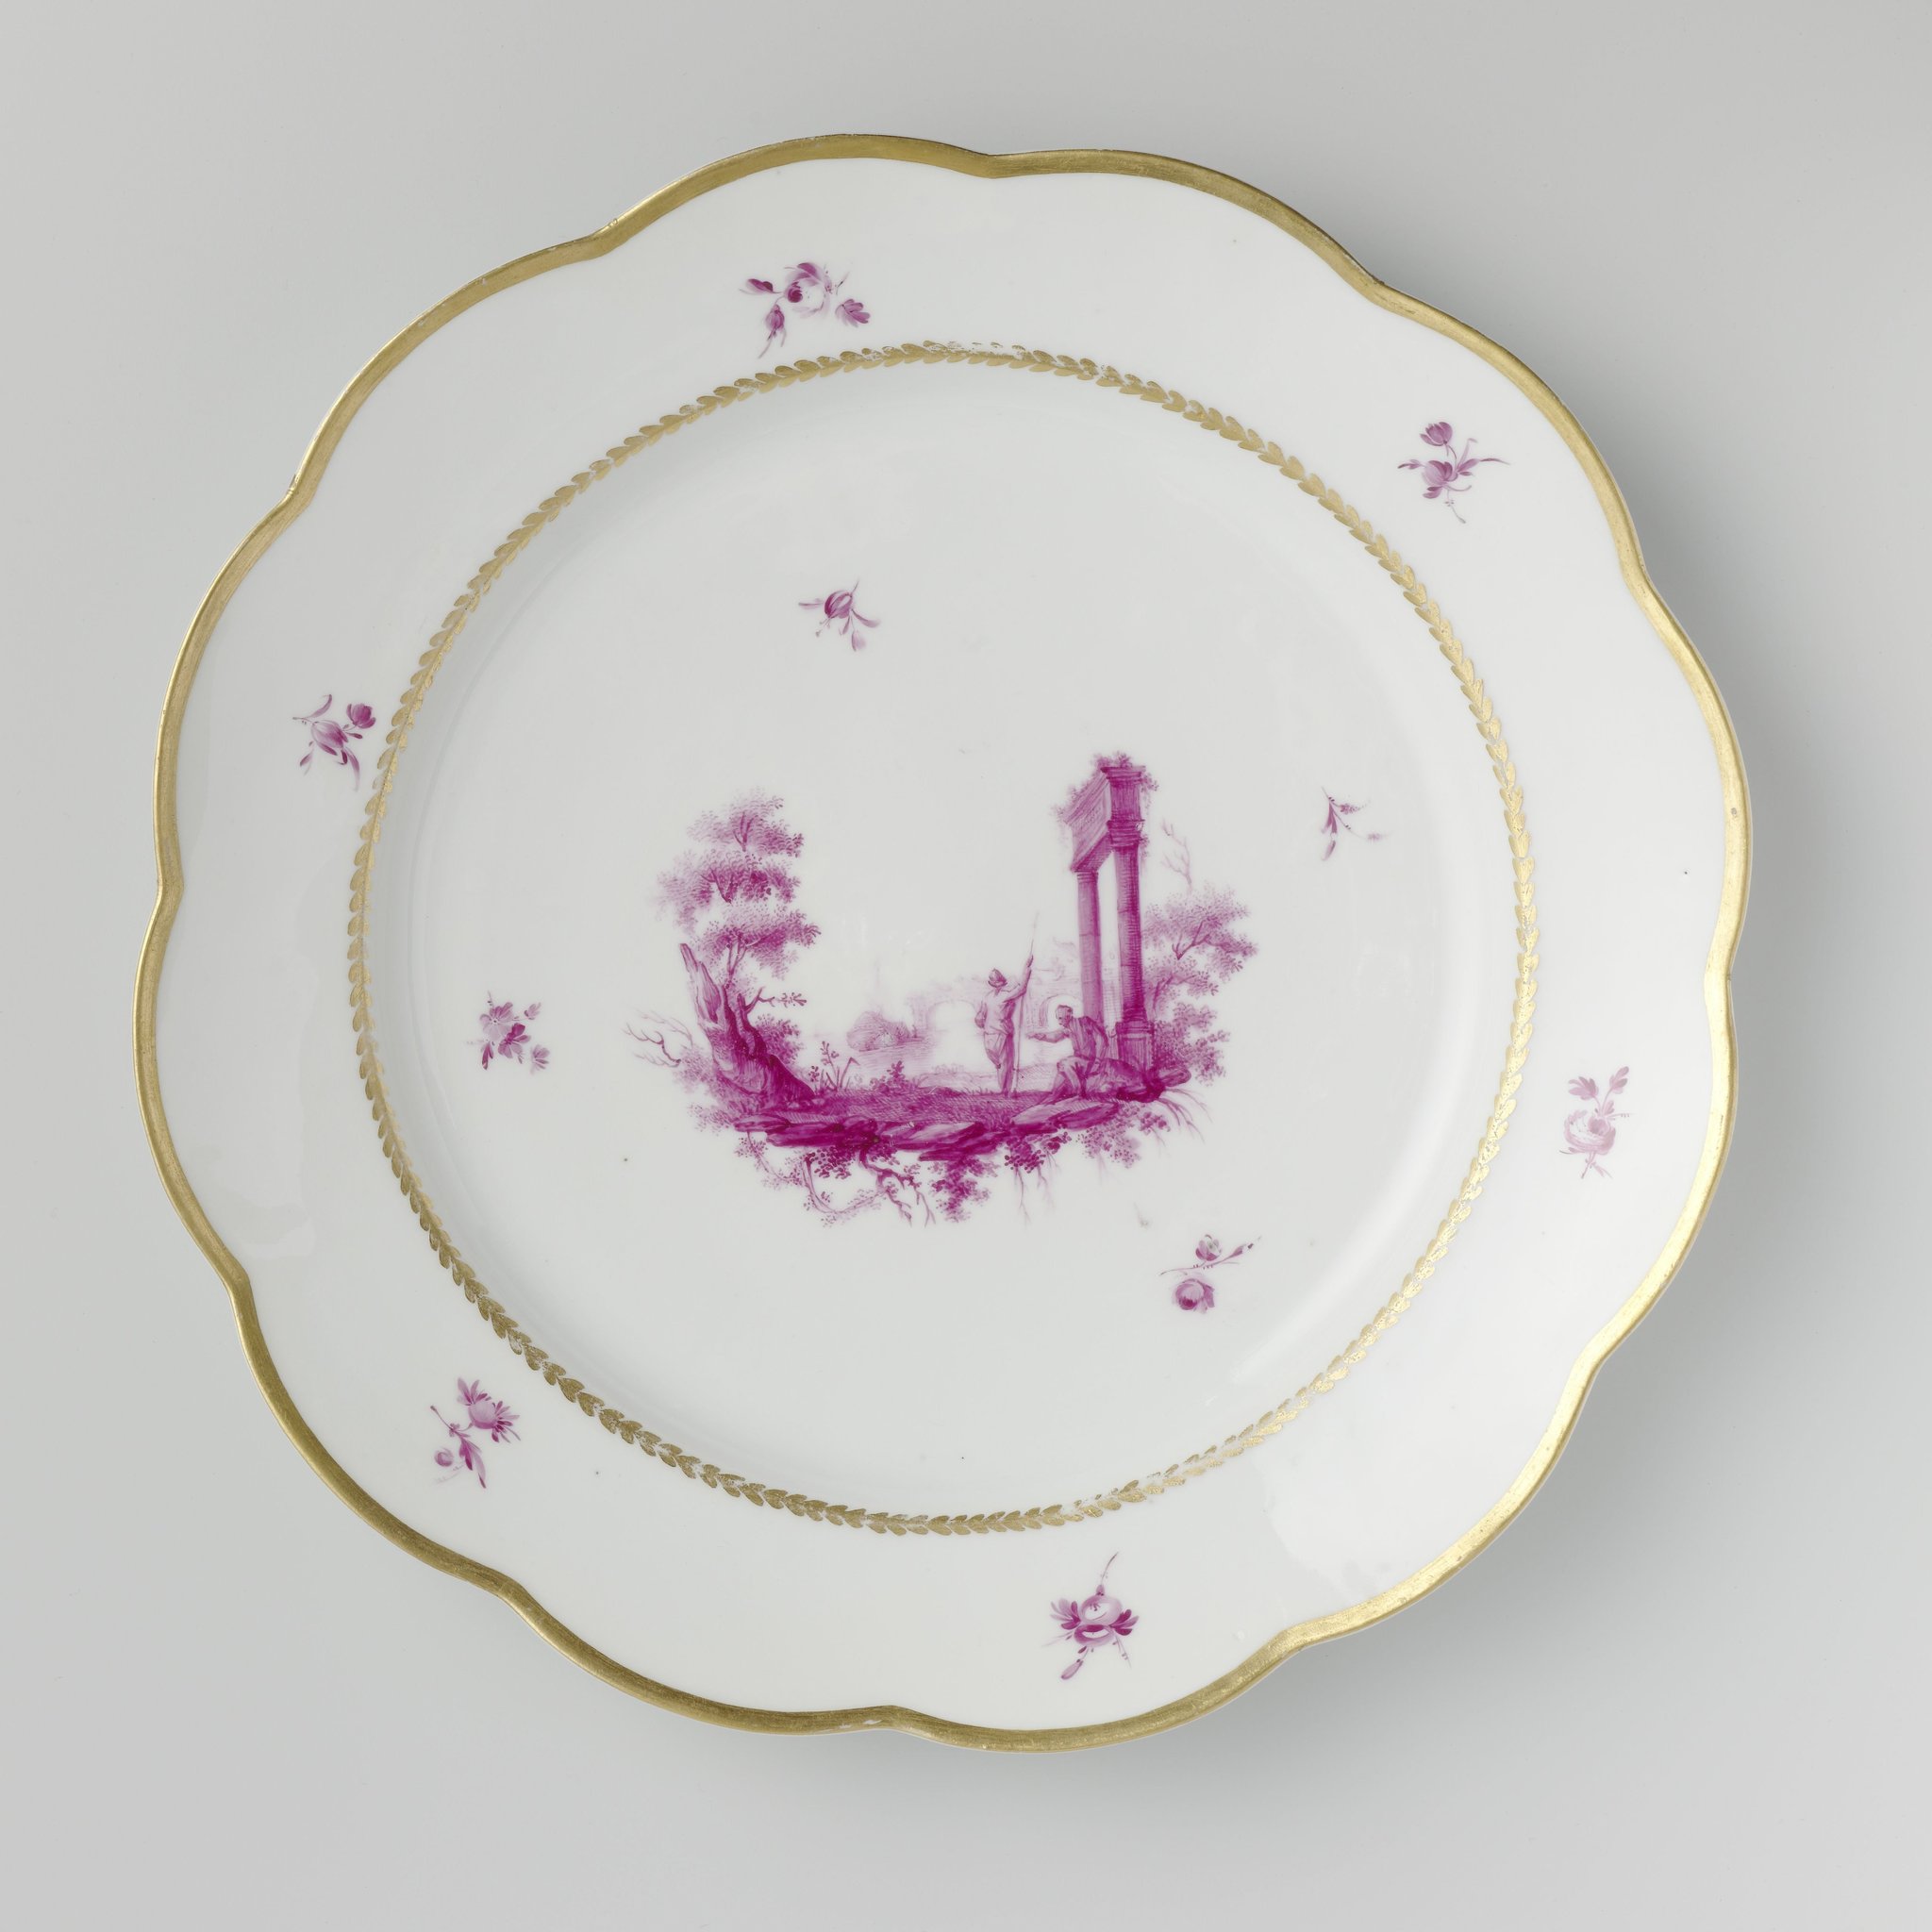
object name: plate dish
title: Plate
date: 1778-1782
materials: porcelain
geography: loosdrecht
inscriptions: collector's mark: ‘109’, mark: ‘MOL *’, mark: ‘MOL *’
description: Manufactuur Oud-Loosdrecht Loosdrecht, c. 1778–1782 hard-paste porcelain